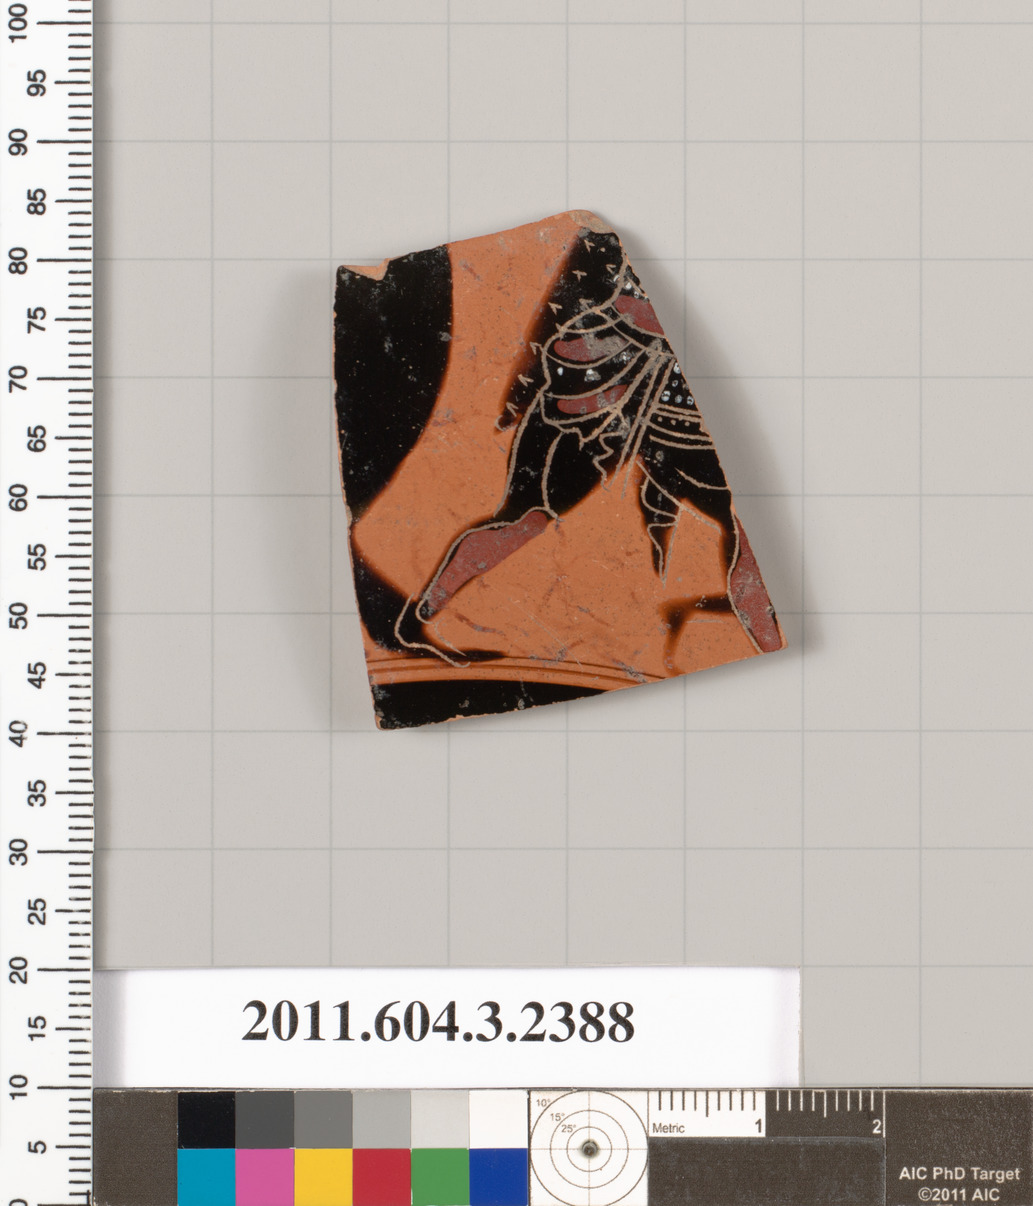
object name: kylix fragment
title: Terracotta fragment of a kylix: eye-cup (drinking cup)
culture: greek, attic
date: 530-510 BCE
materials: terracotta